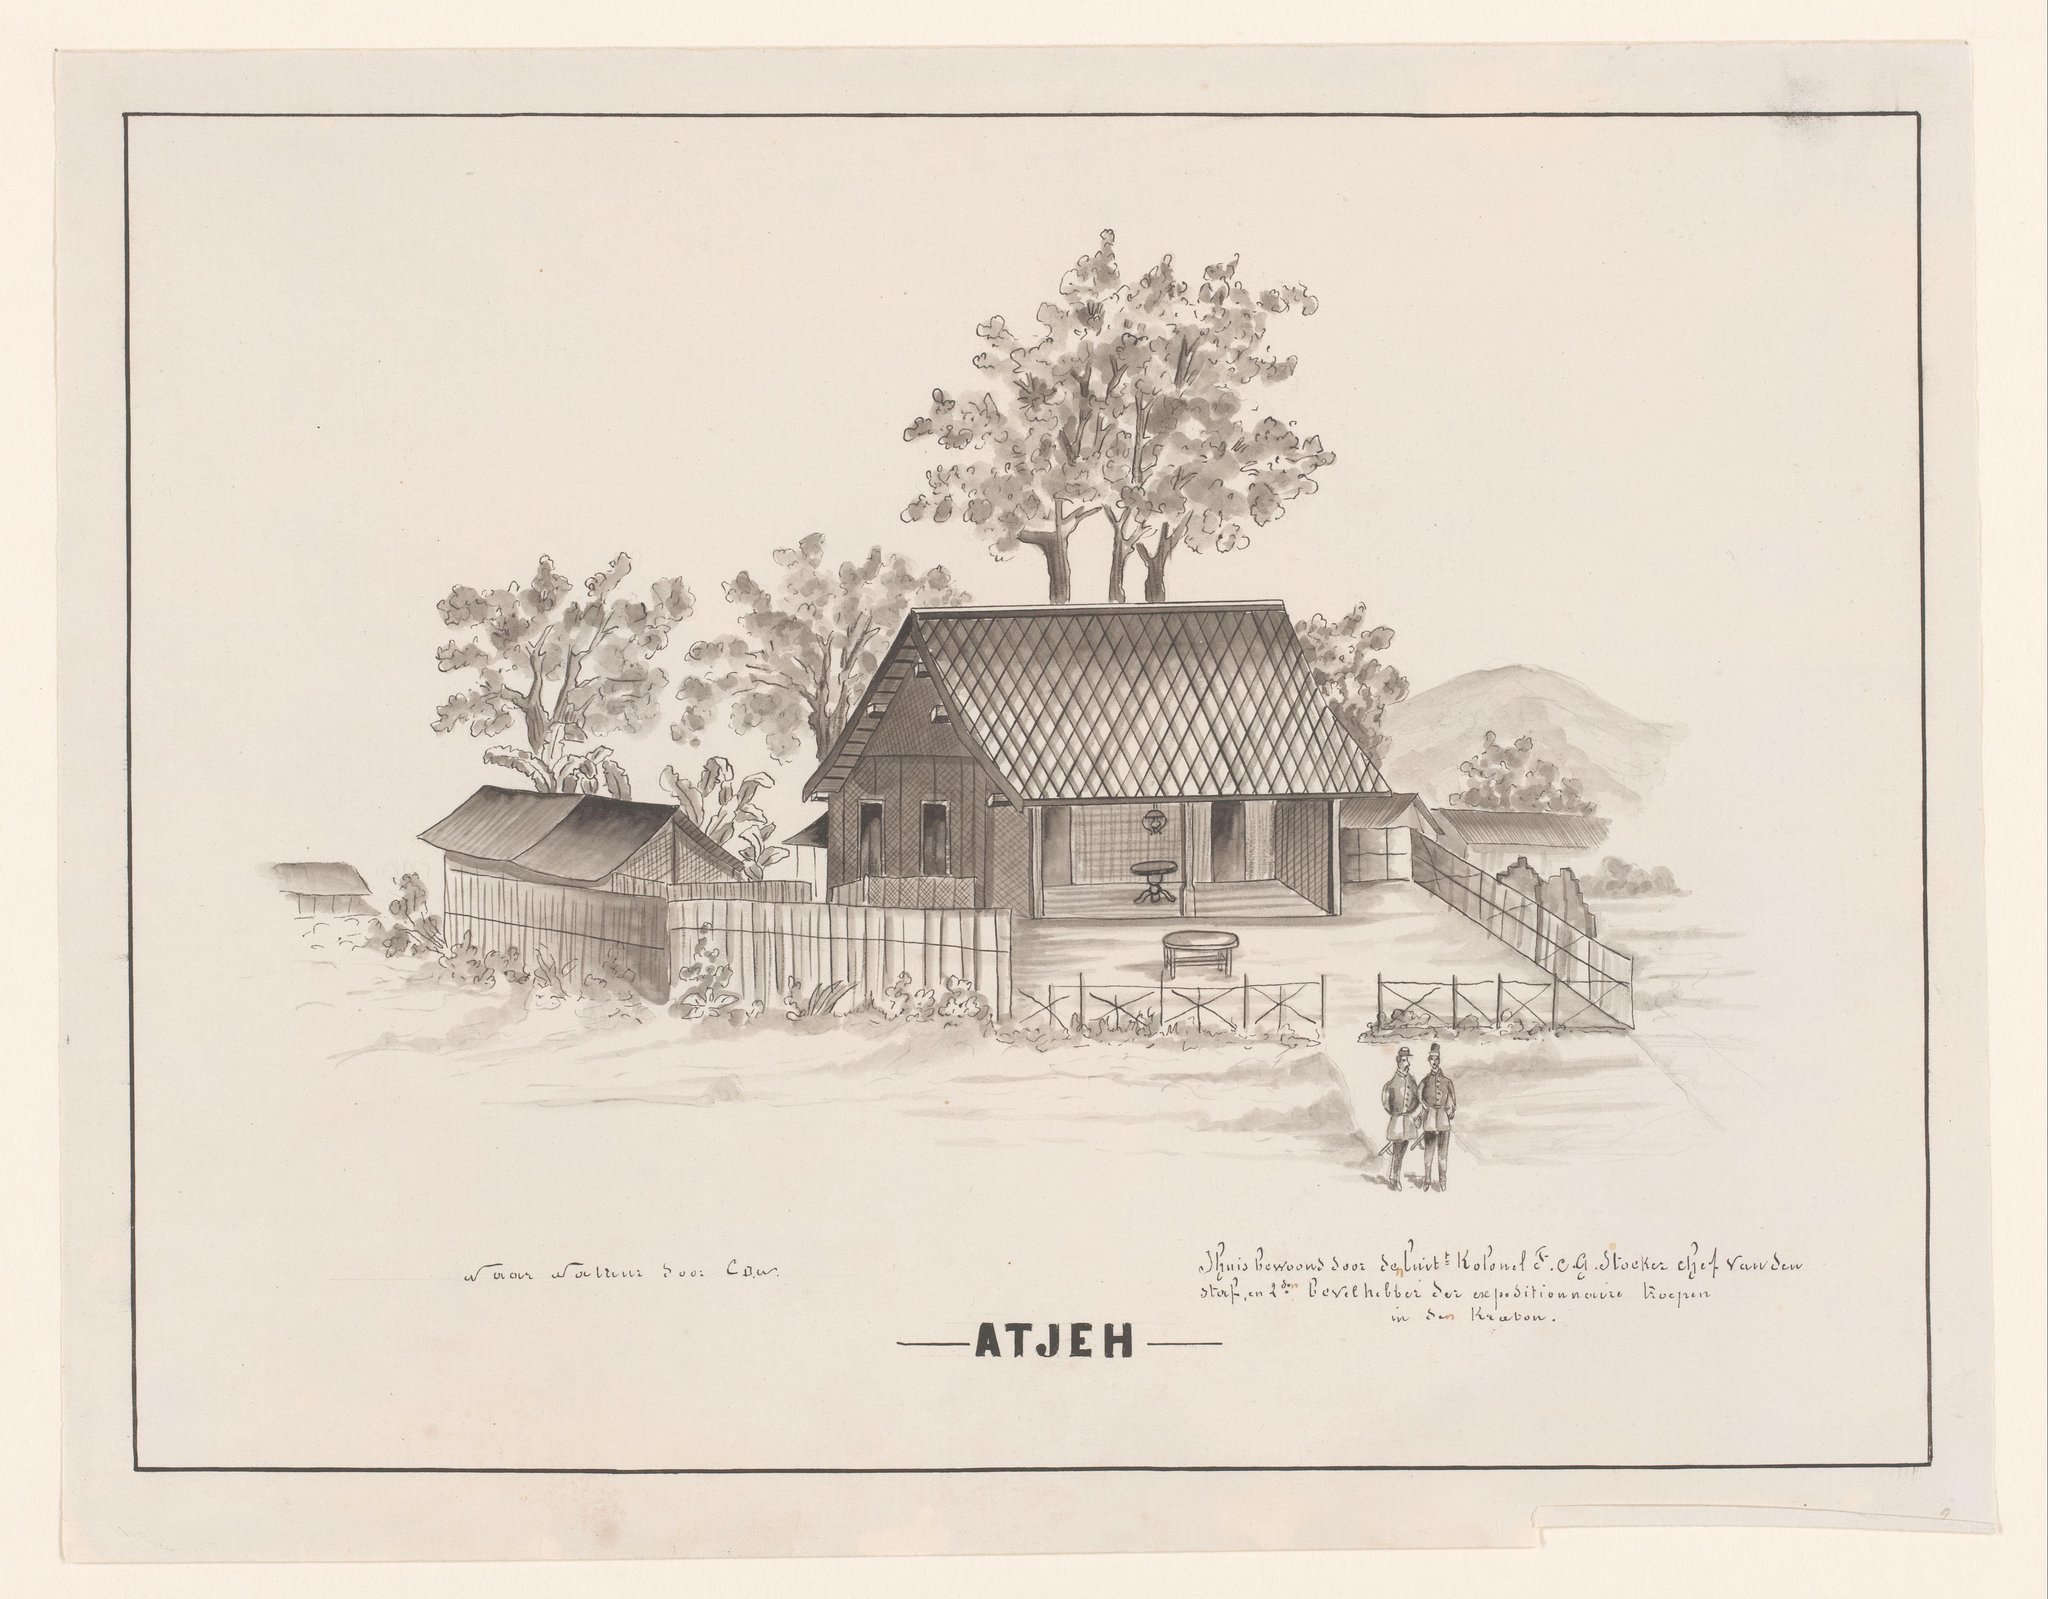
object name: drawing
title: Atjeh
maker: c.d. wulf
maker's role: draughtsman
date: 1874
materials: ink, paper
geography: aceh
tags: civic architecture; edifices; dwellings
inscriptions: inscription: ‘naar natuur door C.D.W. / Huis bewoond door de luitt. Kolonel F.C.G. Stocker chef van den staf, en 2den bevelhebber der expeditionnaire troepen in den Kraton. / - Atjeh -’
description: Huis van luitenant-kolonel F.C.G. Stocker, chef staf en tweede bevelhebber van de expeditionnaire troepen in de Kraton (Kota Radja) met bijgebouwen in omheining onder loofbomen. Voor de ingang van het hek 2 mannen in militaire uniformen. In de tuin voor het huis een tafel; op de overdekte waranda een tafel met een lamp erboven.